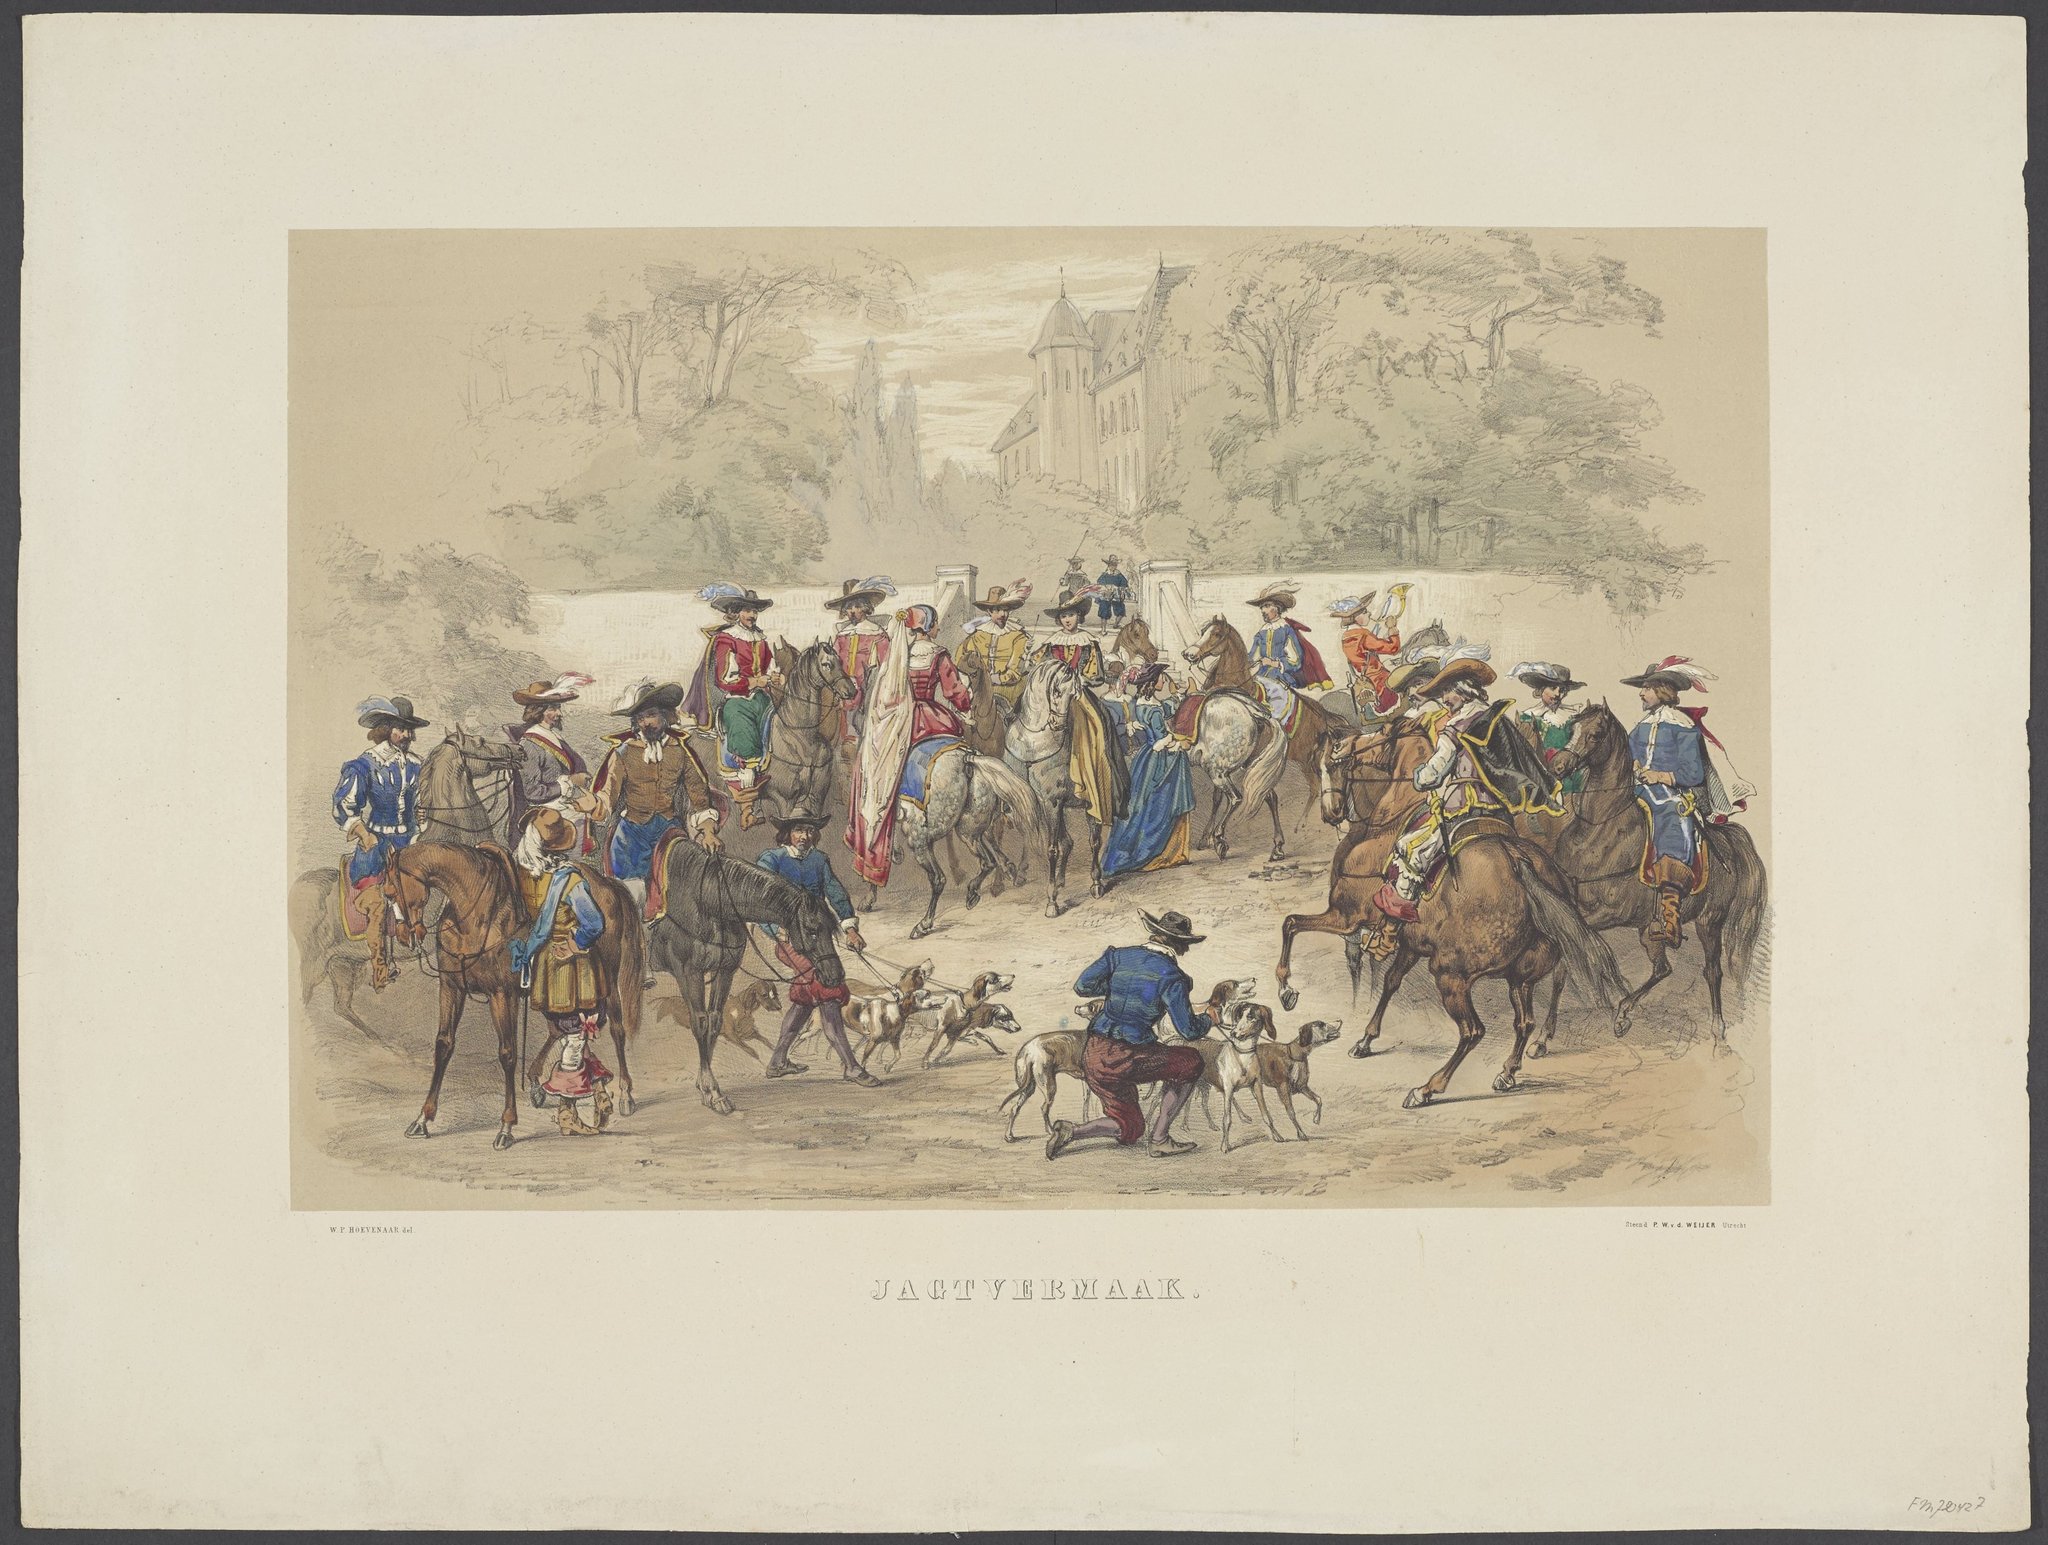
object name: print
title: Utrechtse maskerade van 1856, plaat 7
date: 1856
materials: paper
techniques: hand coloring, lithograph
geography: utrecht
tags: students' pageant, hunting, chase, costumes used in pageants, utrecht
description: Adellijke mannen en jonkvrouwen maken zich gereed voor een jachtpartij. Onderdeel van de groep van zeven platen met verklaring van de historische optocht in maskerade opgevoerd door de studenten van de vereniging Mutua Fides van de Utrechtse Hogeschool op 25 juni 1856 ter gelegenheid van de viering van haar 220-jarige bestaan.